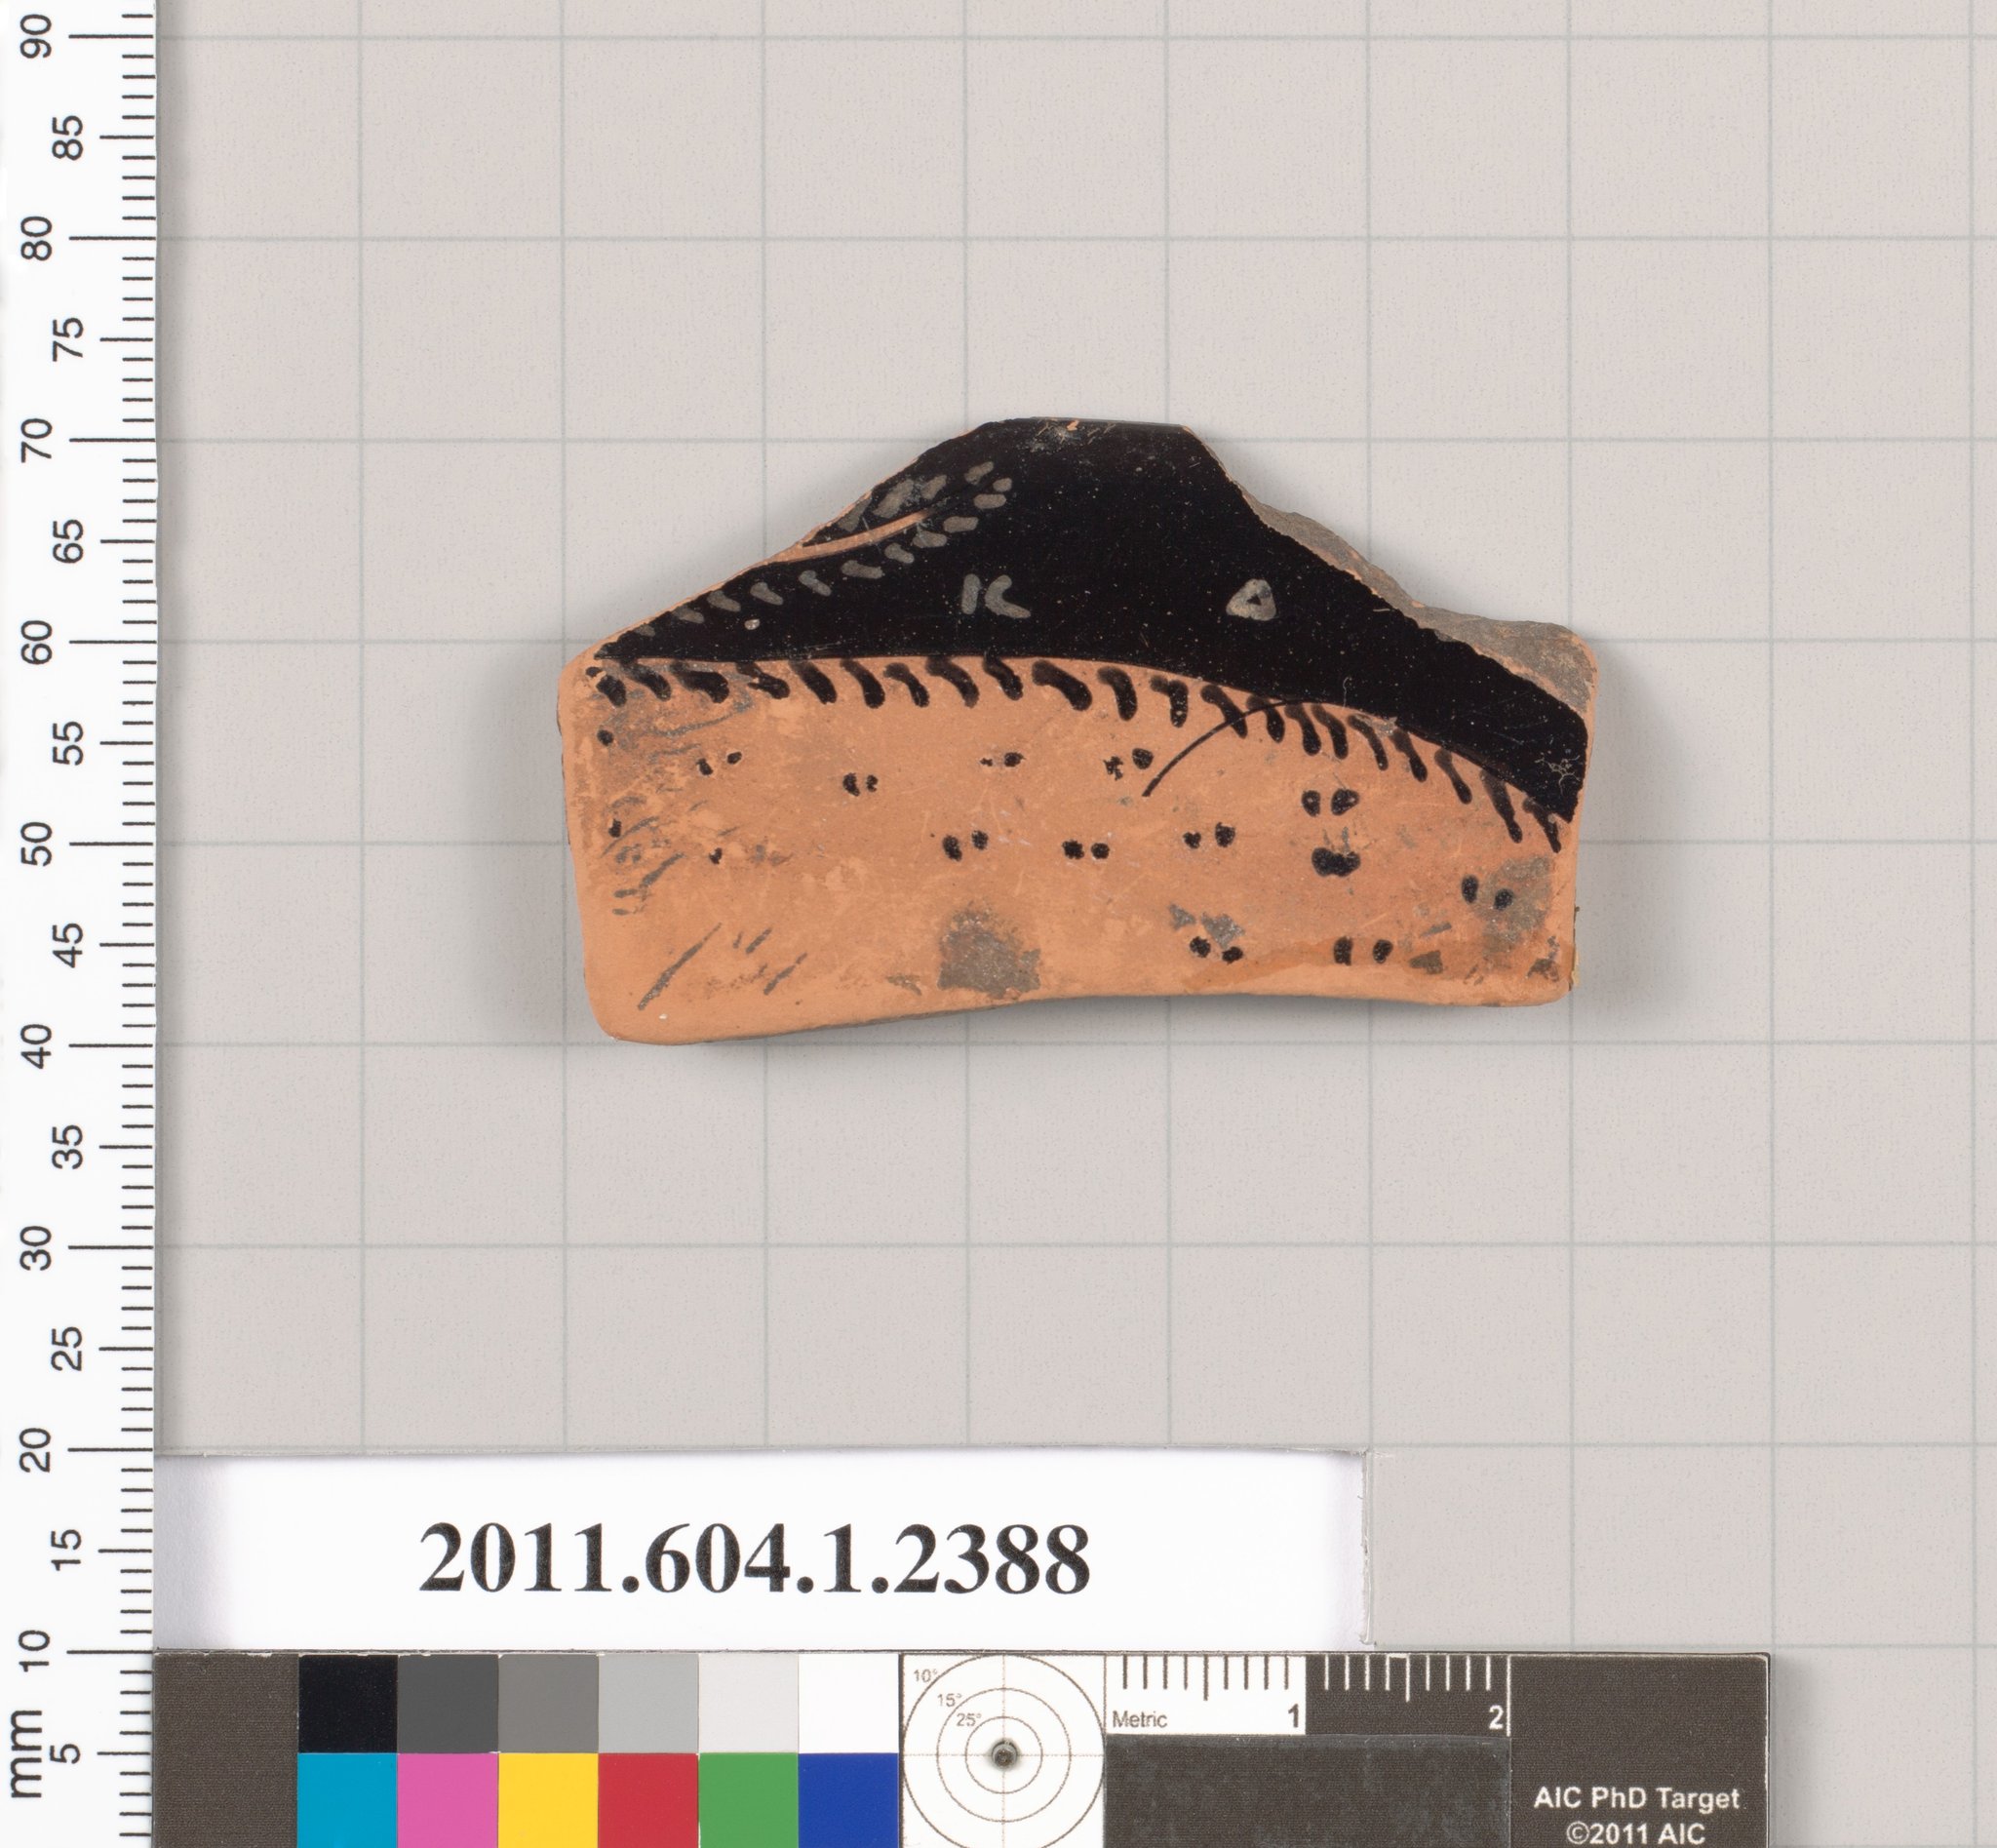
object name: kylix fragment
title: Terracotta rim fragment of a kylix (drinking cup)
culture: greek, attic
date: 520-500 BCE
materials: terracotta